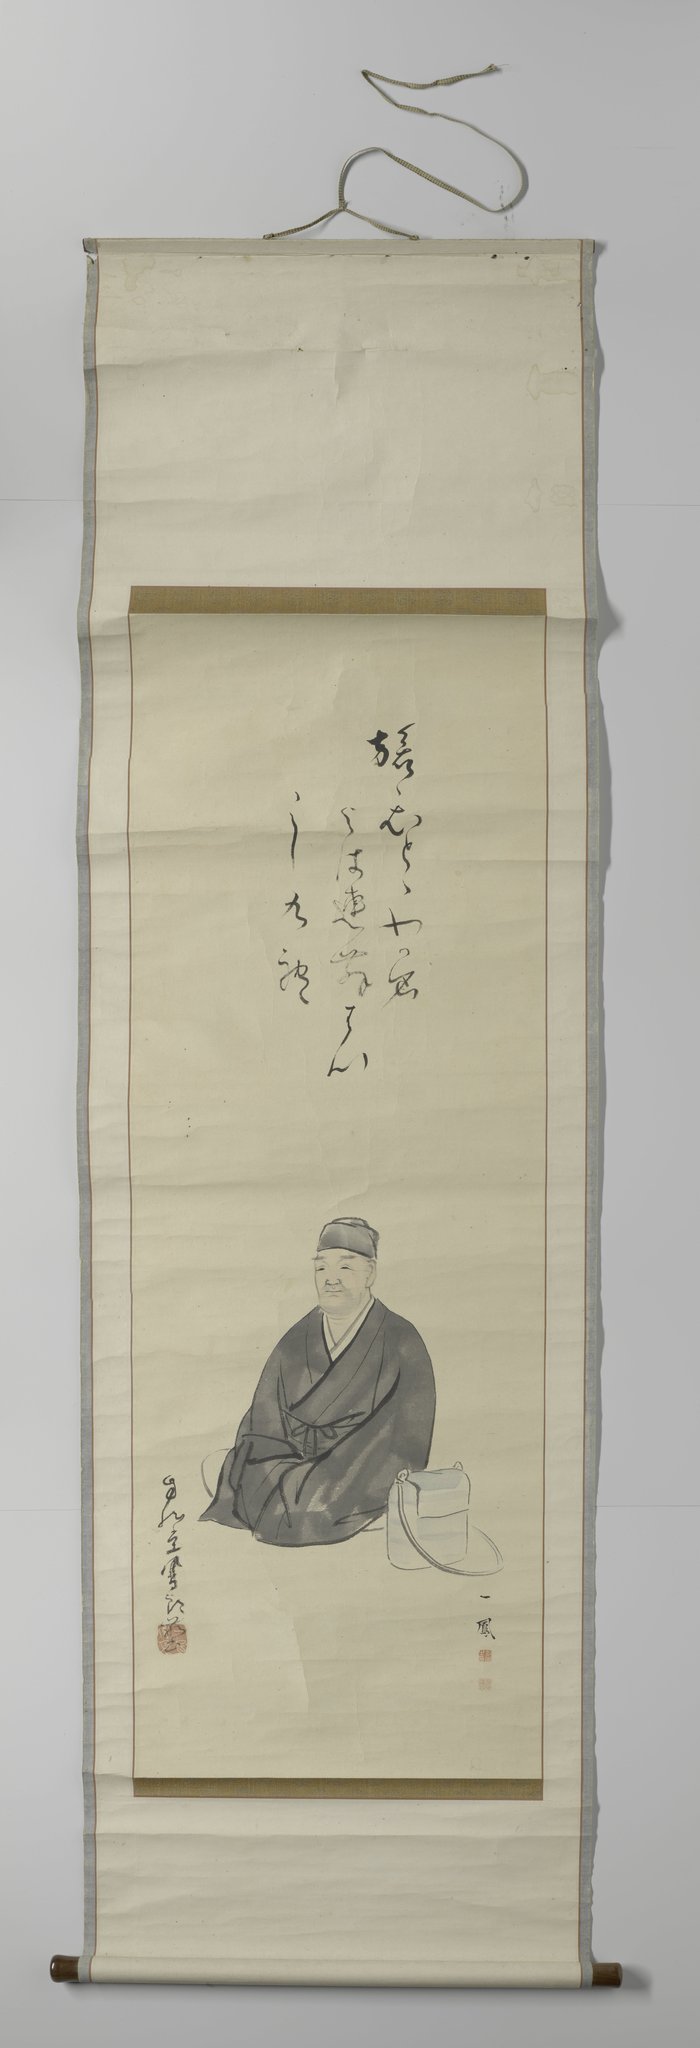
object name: hanging scroll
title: De dichter Bashô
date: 1820-1840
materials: dye, ink, paper, wood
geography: japan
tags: dichter, bashô matsuo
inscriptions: : ‘9/VI/'54’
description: Afbeelding van een zittende man, de dichter Bashô, met links van zich een tas. Inscriptie door Hôrô midden boven. Montering in bunjin-stijl. Ichimonji van bruin zilverbrokaat, chûmawashi van beige papier, minchô van rood papier, hashira van blauw papier, jikusaki van bruin hout. In houten doos.